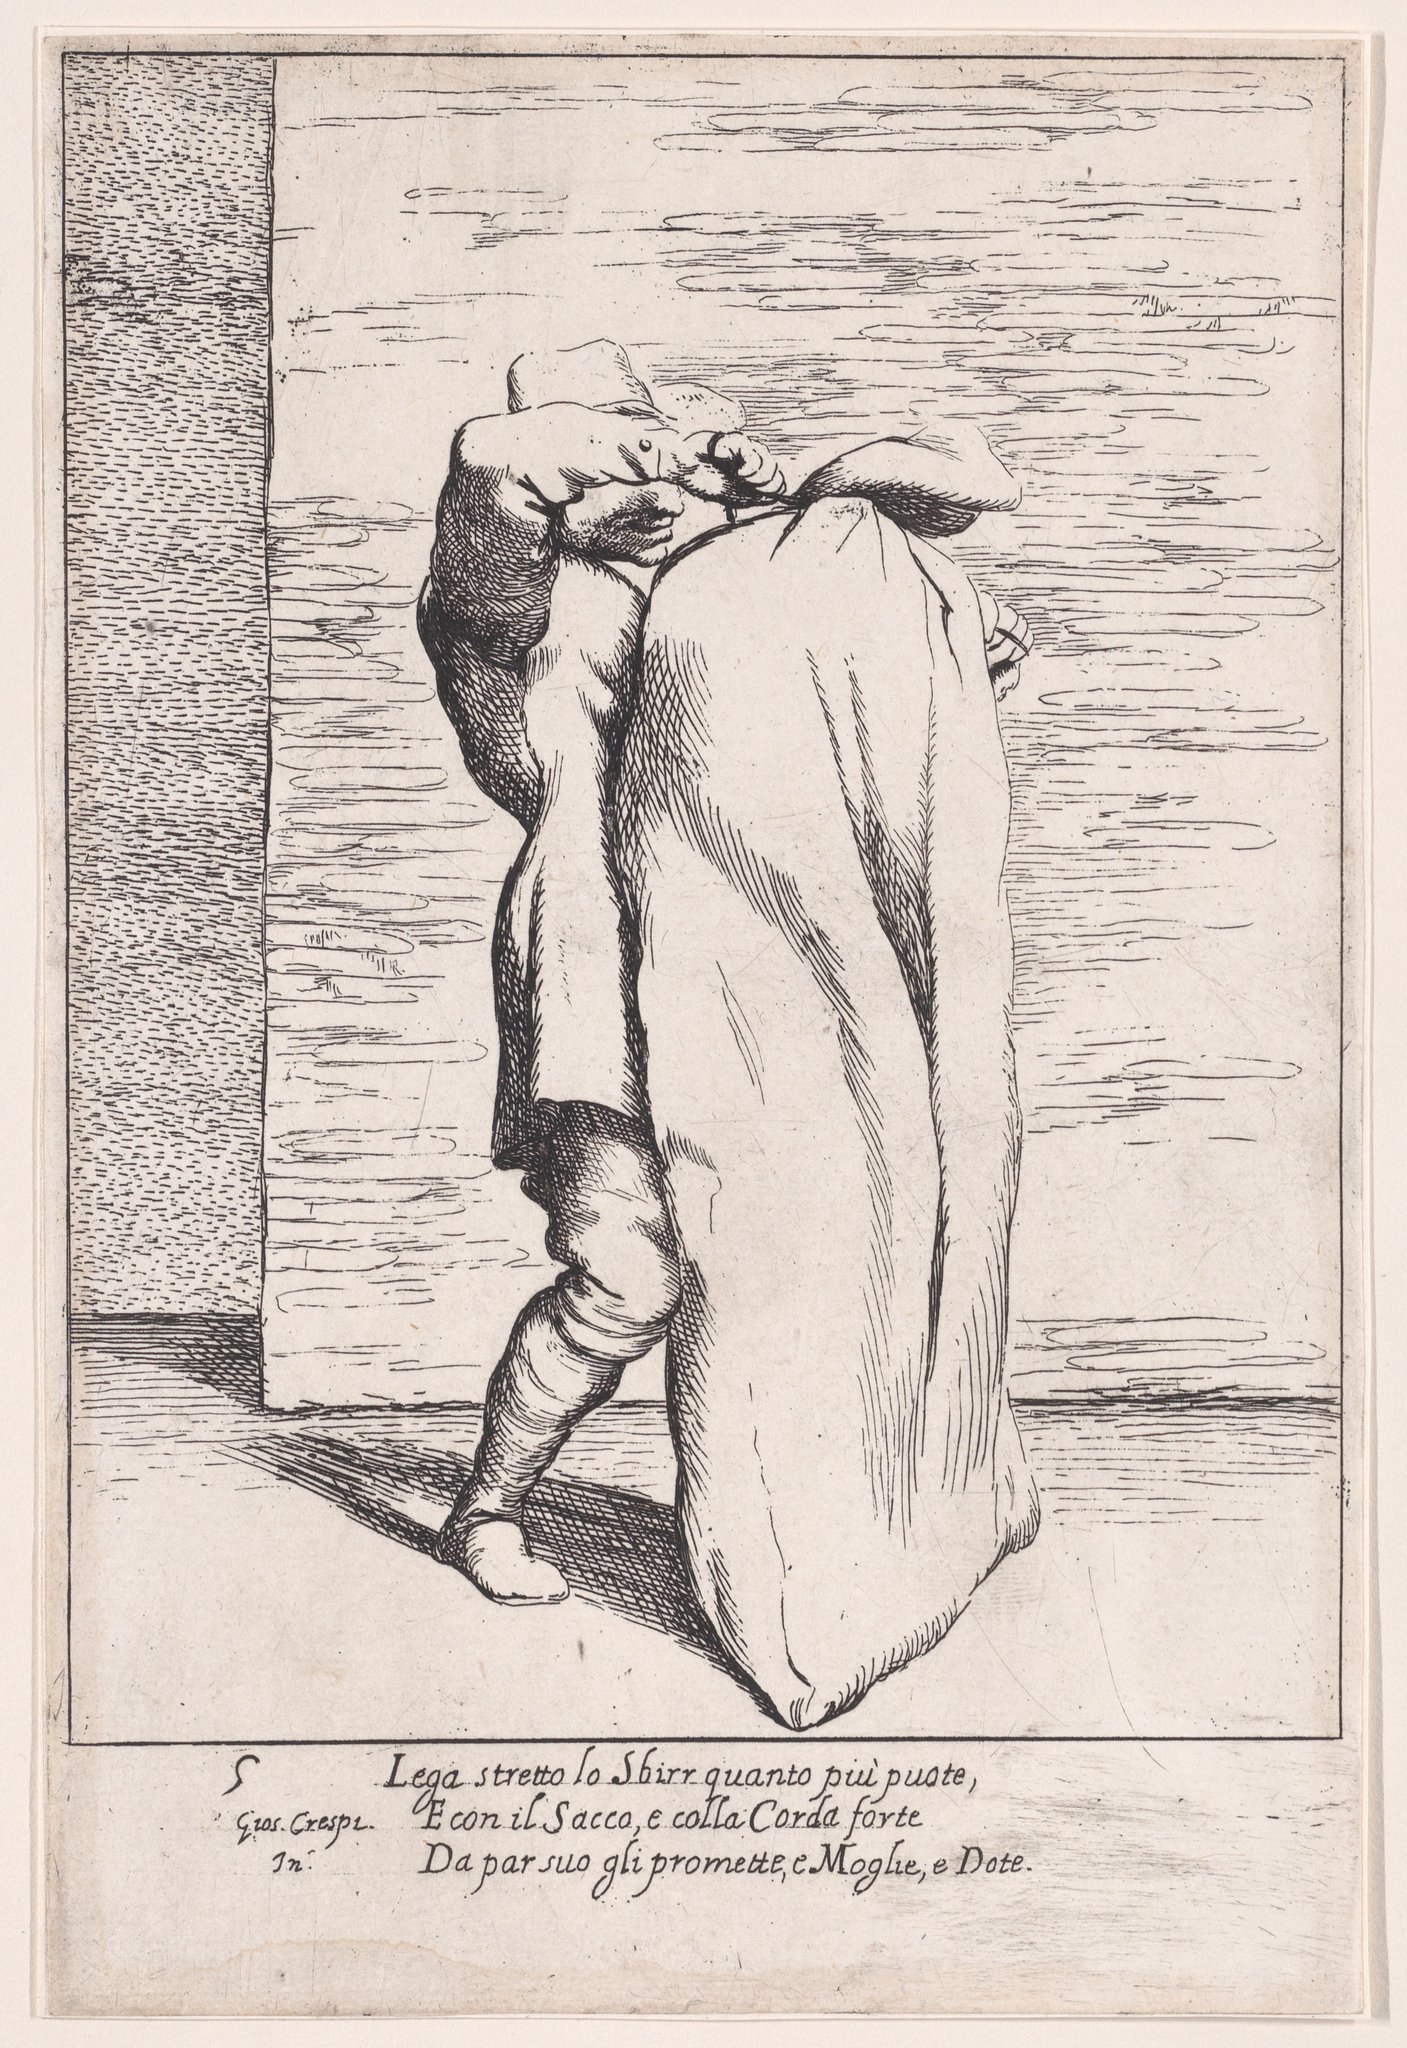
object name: print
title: Plate 5: Bertoldo putting the jailor into the sack, from "Bertoldo, Bertoldino, and Cacasenno"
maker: giuseppe maria crespi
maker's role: artist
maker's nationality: italian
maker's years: 1665-1747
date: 1705-1715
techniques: etching